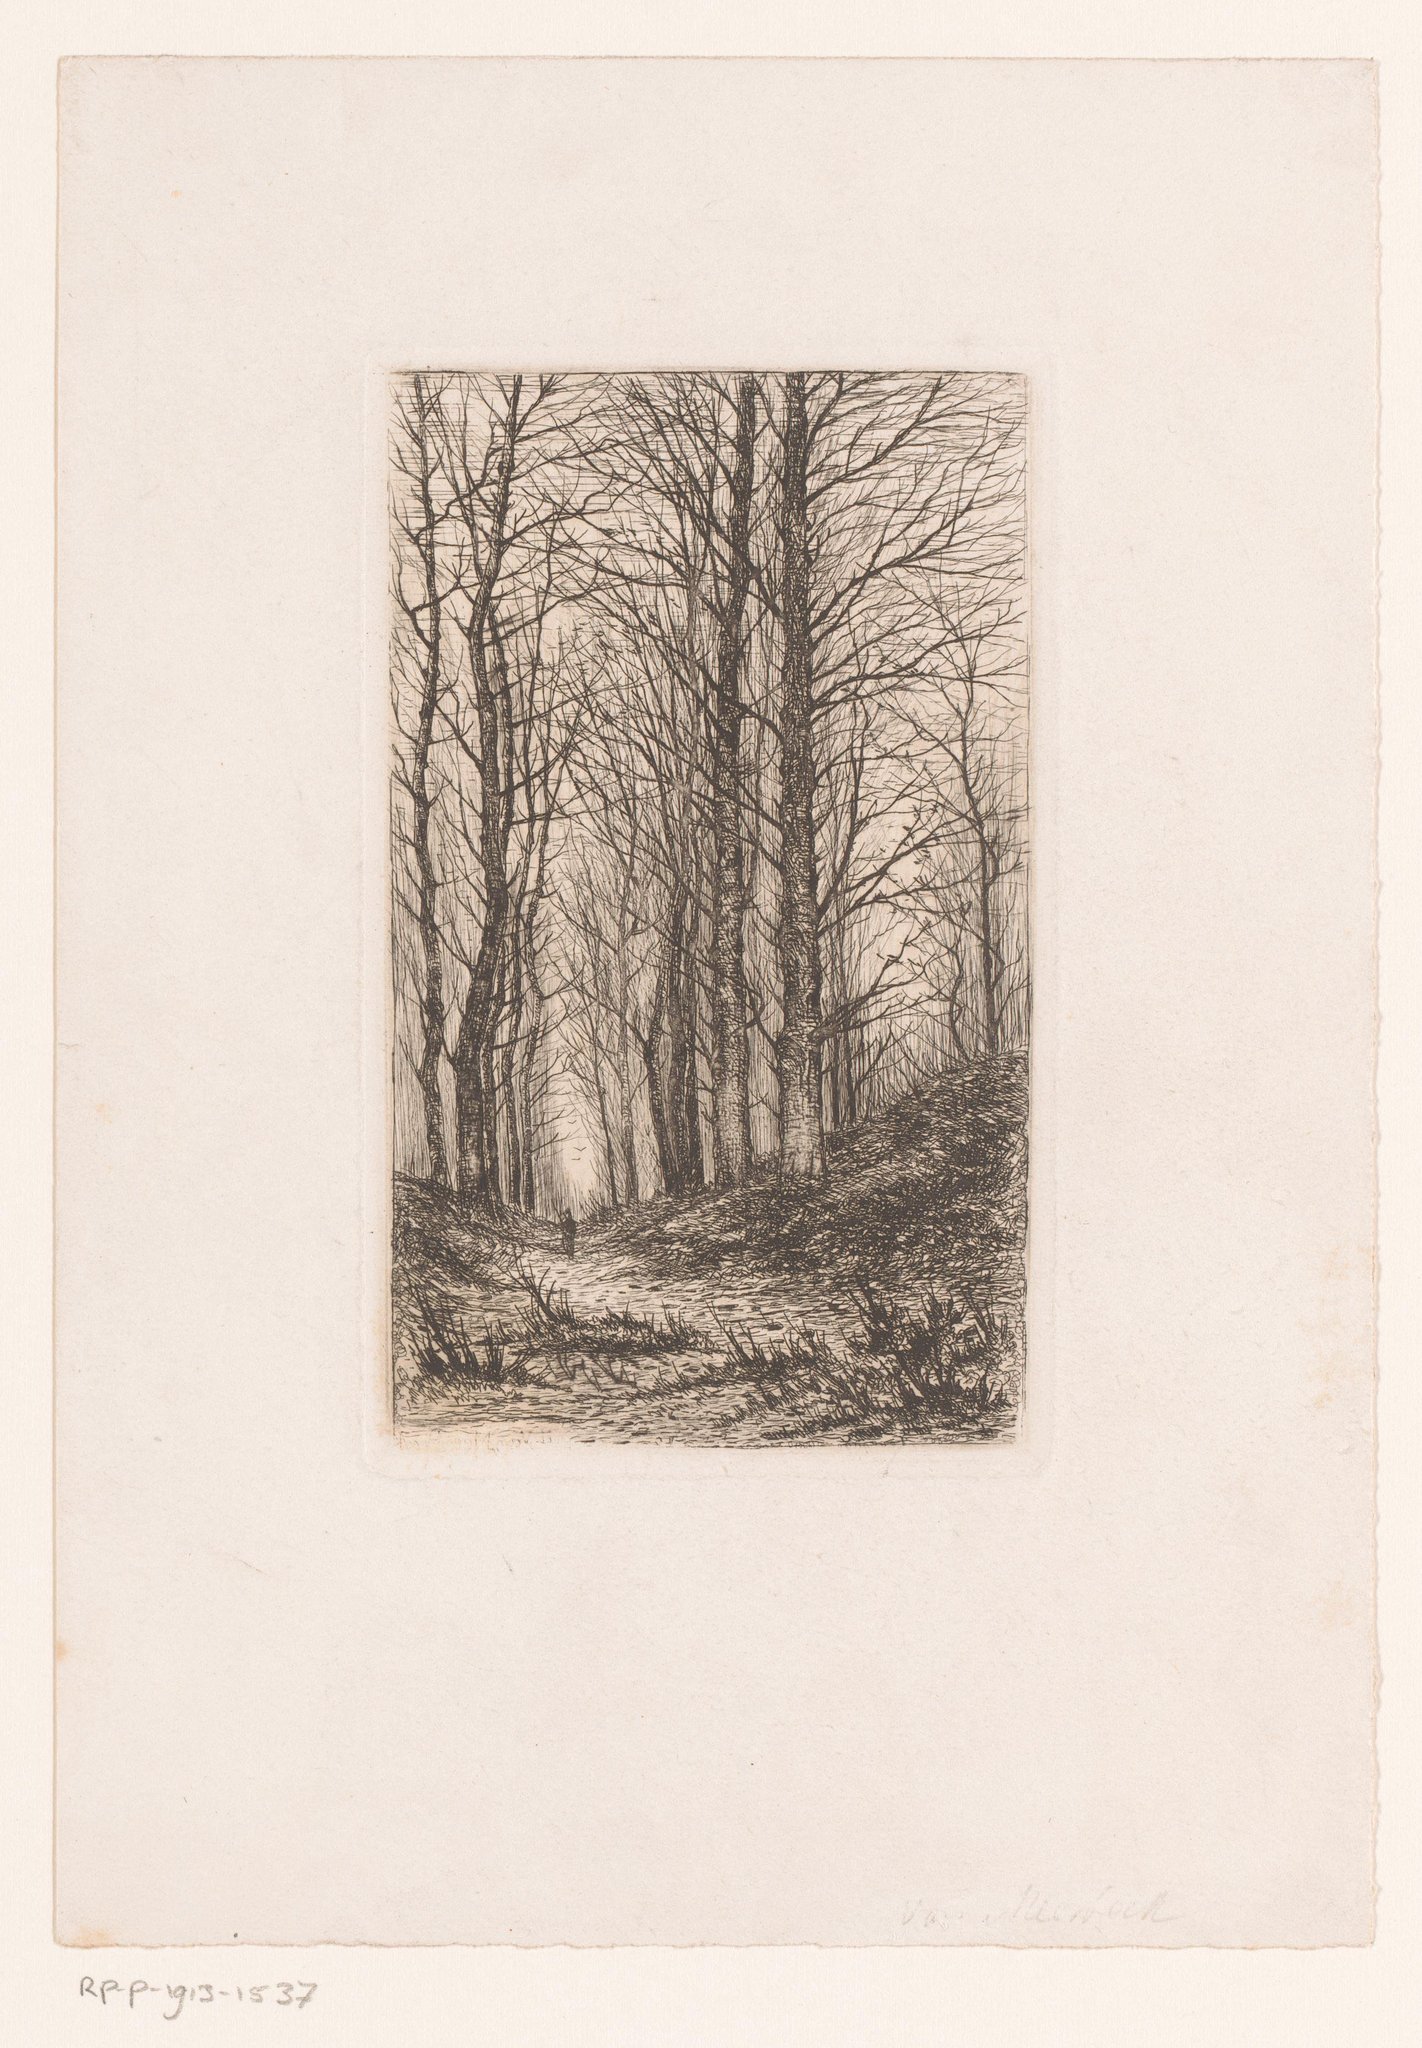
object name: print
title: Wandelaar op een heuvelachtig bospad met hoge, kale bomen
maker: h. van meerbeeck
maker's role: print maker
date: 1850-1913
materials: paper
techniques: etching, intaglio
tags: trees, forest path or lane (+ landscape with figures, staffage)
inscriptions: collector's mark: Lugt 2228